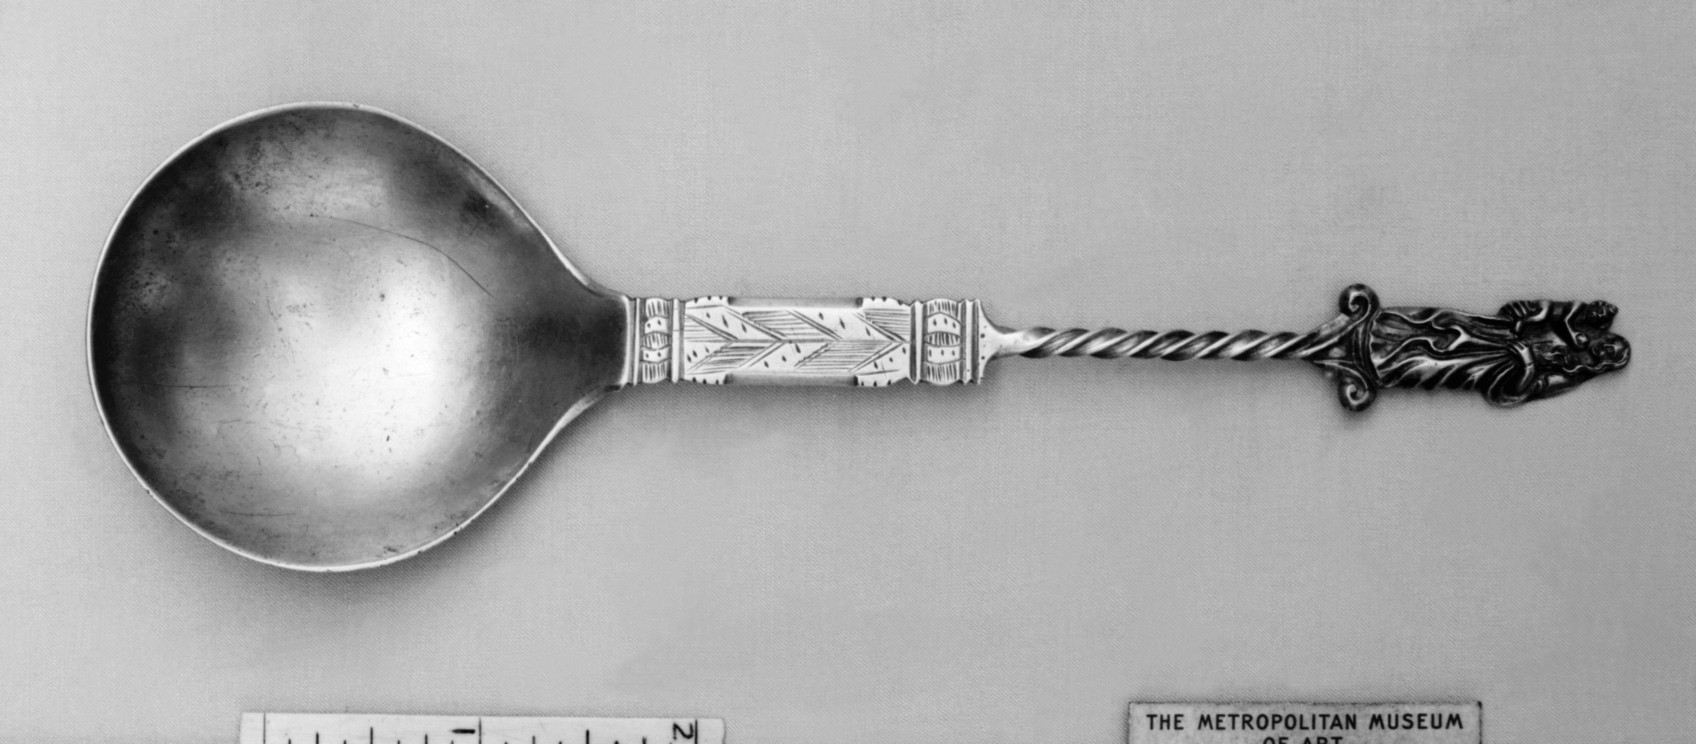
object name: spoon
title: Figure-top spoon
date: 1851-1900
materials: silver gilt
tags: mothers